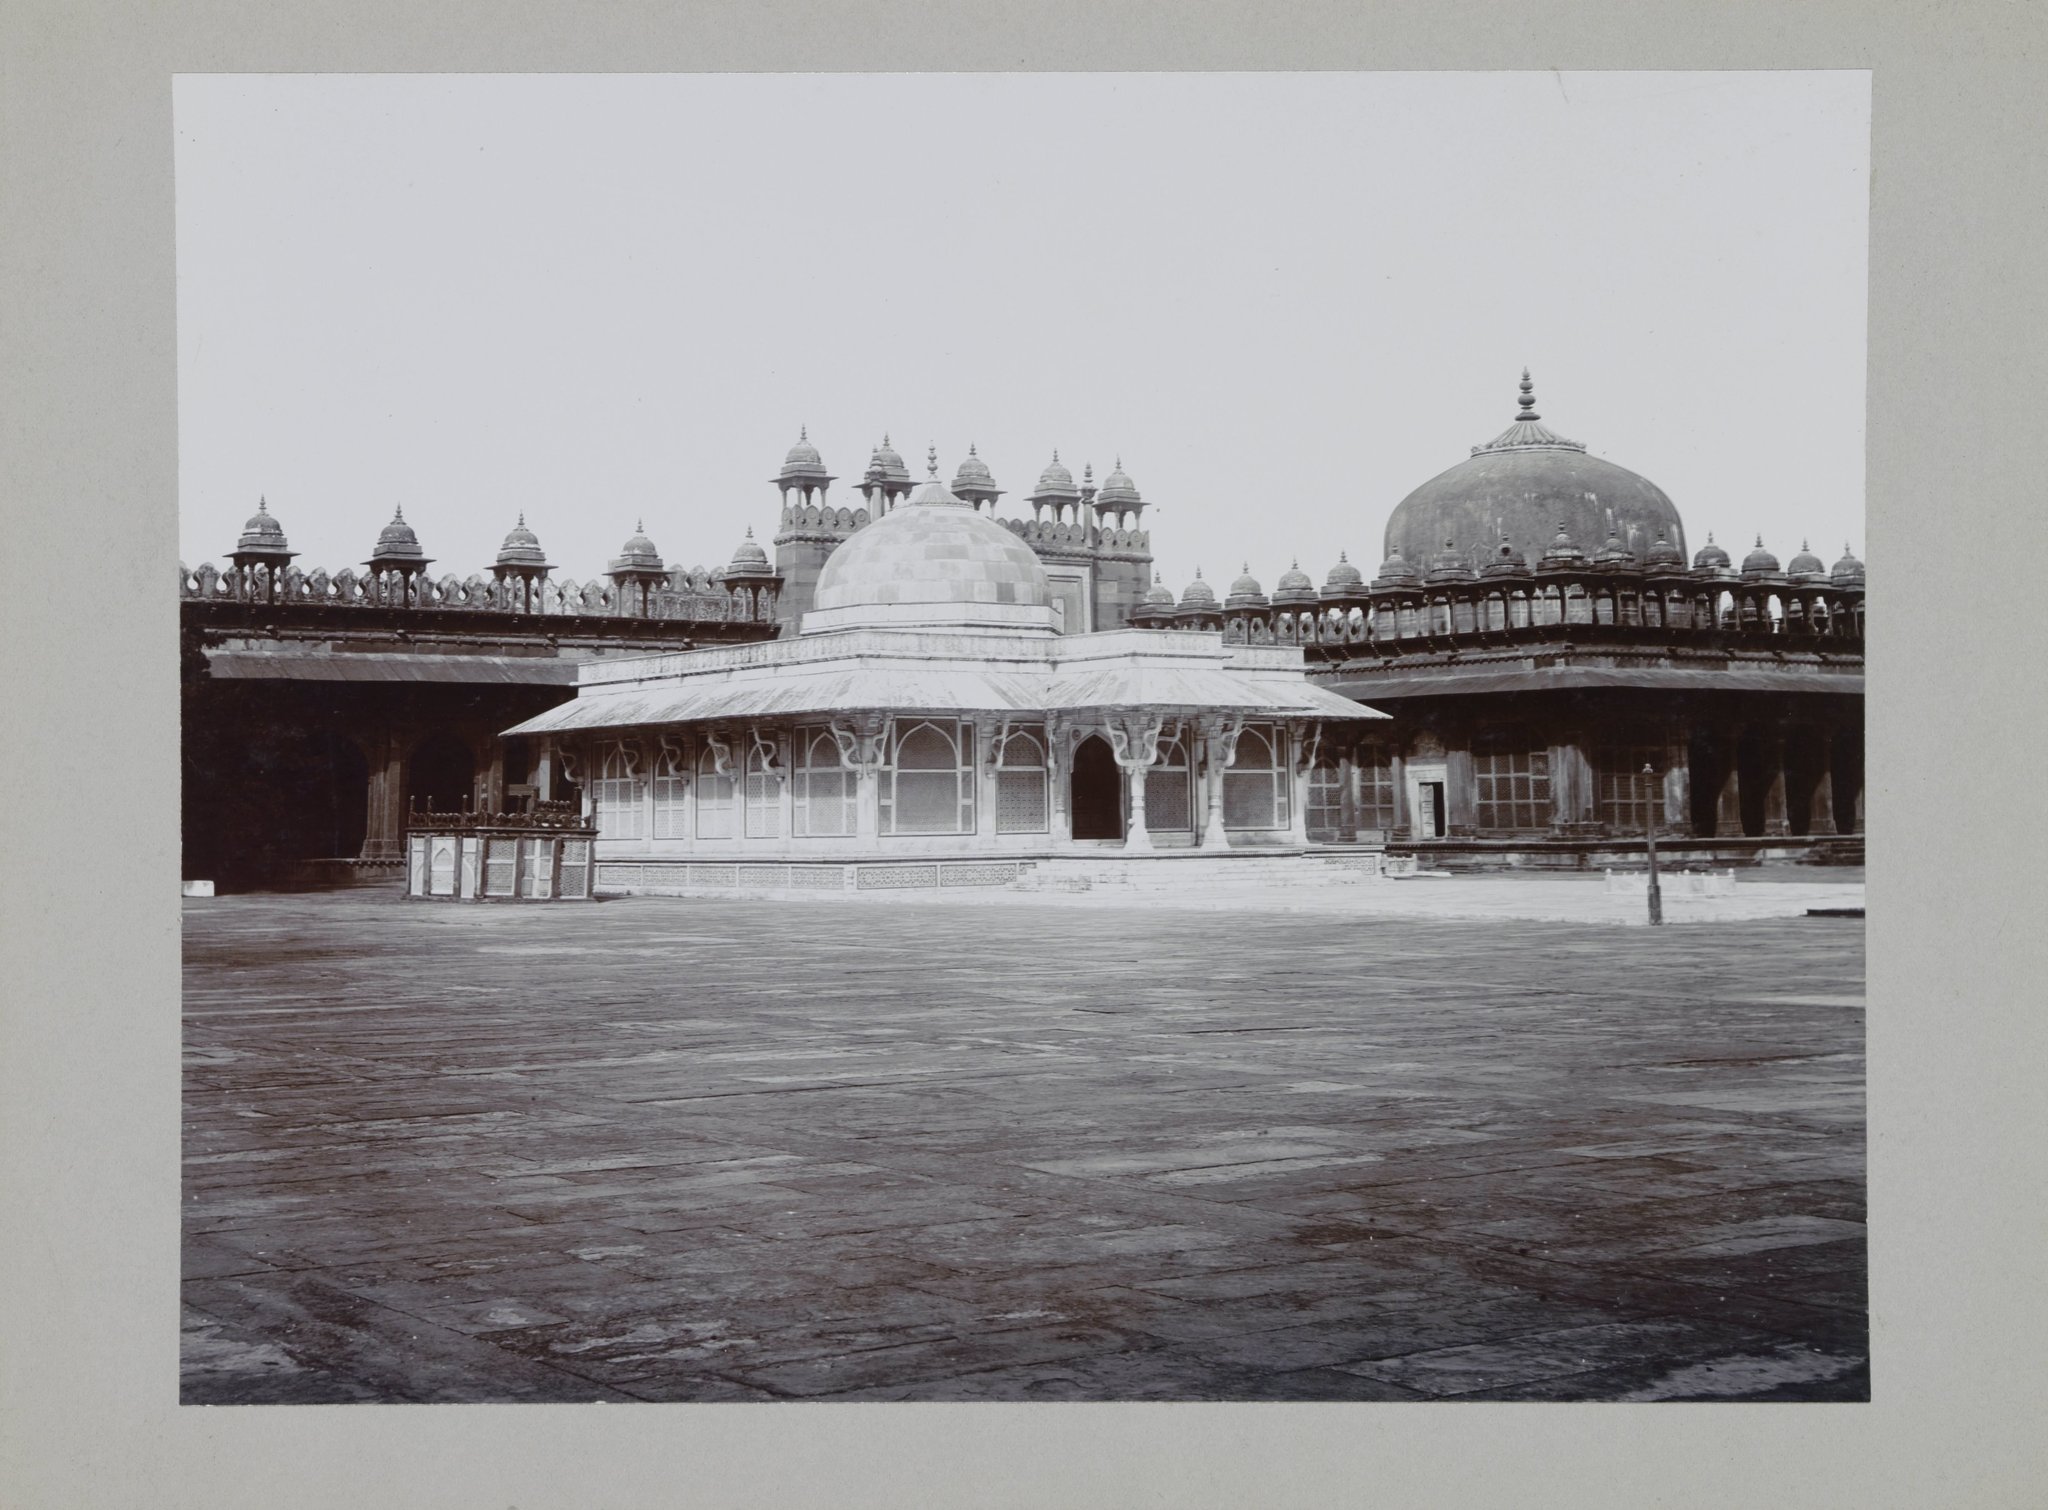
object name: photograph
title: Tomb of Salim Chisti in Fatehpur Sikri, Uttar Pradesh, India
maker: Anonymous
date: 1895-1915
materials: cardboard, paper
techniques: gelatin silver print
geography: fatehpur sikri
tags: fatehpur sikri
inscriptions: annotation: ‘48. Moskee met graf v/e priester te Tatehpur Sikri.’